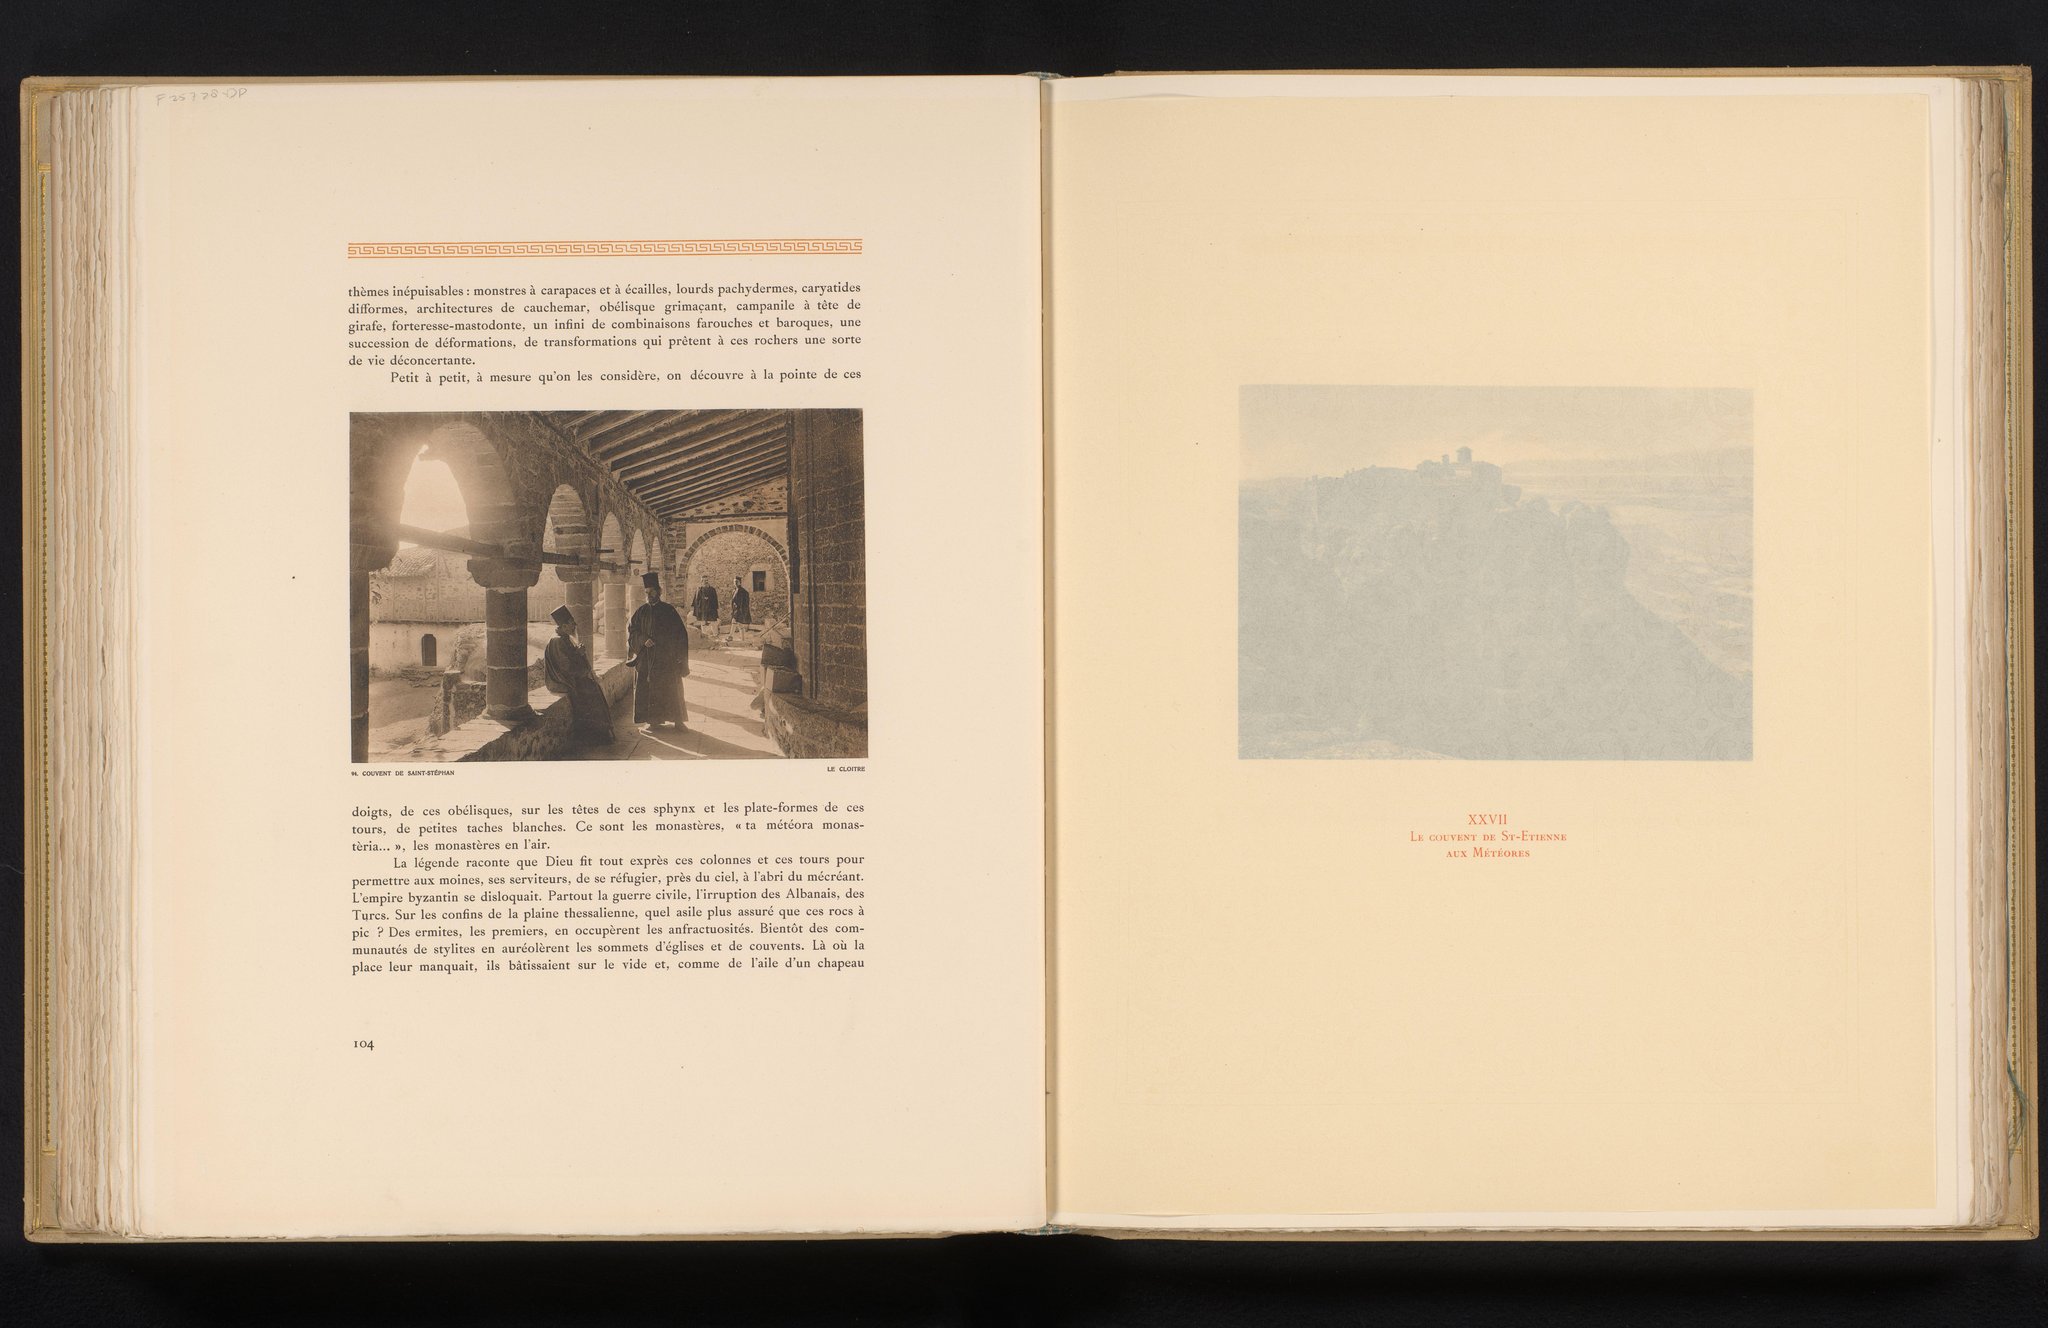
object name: page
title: Kloostergang in het klooster van Agios Stefanos in de Meteora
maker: frédéric boissonnas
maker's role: fotograaf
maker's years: 1858-1946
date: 1905-1910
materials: paper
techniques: photograph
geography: berlin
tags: parts of church interior: ambulatory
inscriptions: number: ‘94.’